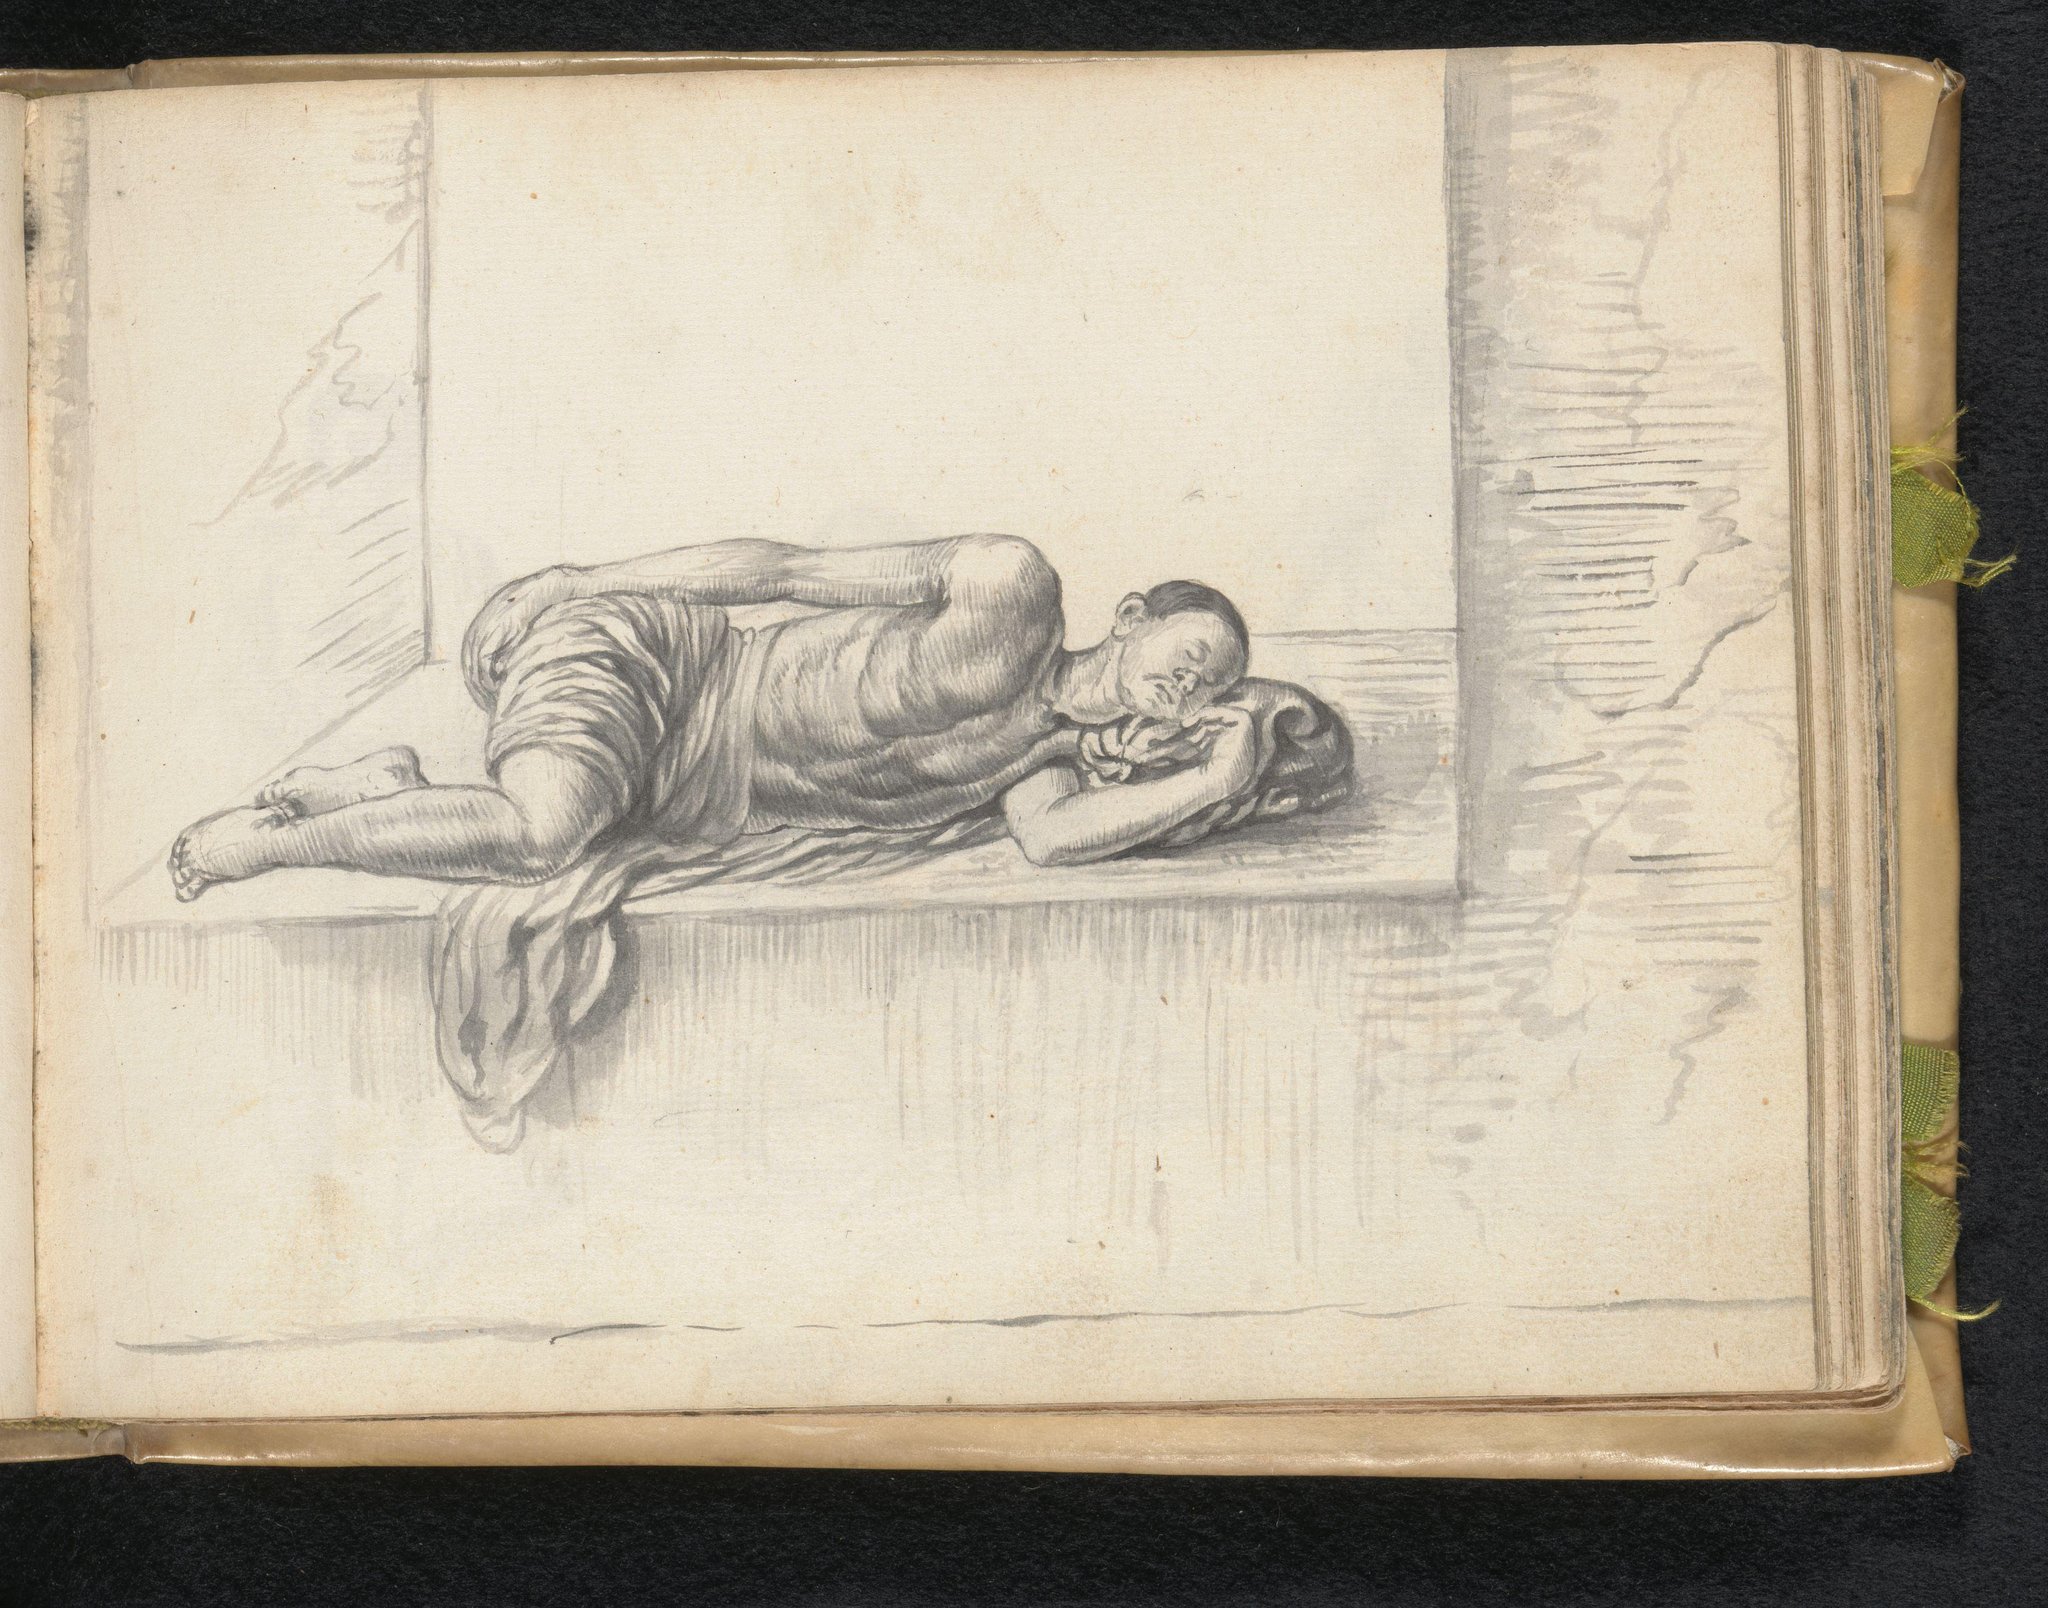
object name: sketchbook leaf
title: Man sleeping on a window-sill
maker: esaias boursse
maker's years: 1631-1672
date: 1662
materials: ink, paper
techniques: brush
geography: sri lanka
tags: 41d232(...) skirt (lungi), head-gear (with name), asiatic races and peoples: indians, sri lanka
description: Op een brede vensterbank (of nis in een muur) ligt een man te slapen. Hij ligt met opgetrokken knieën op zijn linkerzij en draagt een boven de knieën opgetrokken heupdoek (veshti, lungi), waarvan een uiteinde naar voren hangt over de rand; zijn bovenlijf is onbedekt. Onder hem ligt een doek – waarschijnlijk zijn omslagdoek (chadar) die aan het eind is opgerold als ondersteuning voor zijn hoofd. Gezien zijn kleding kan de man afkomstig zijn uit Zuid-India, en te werk gesteld in Colombo. Blad 73 uit een schetsboek met 117 bladen.